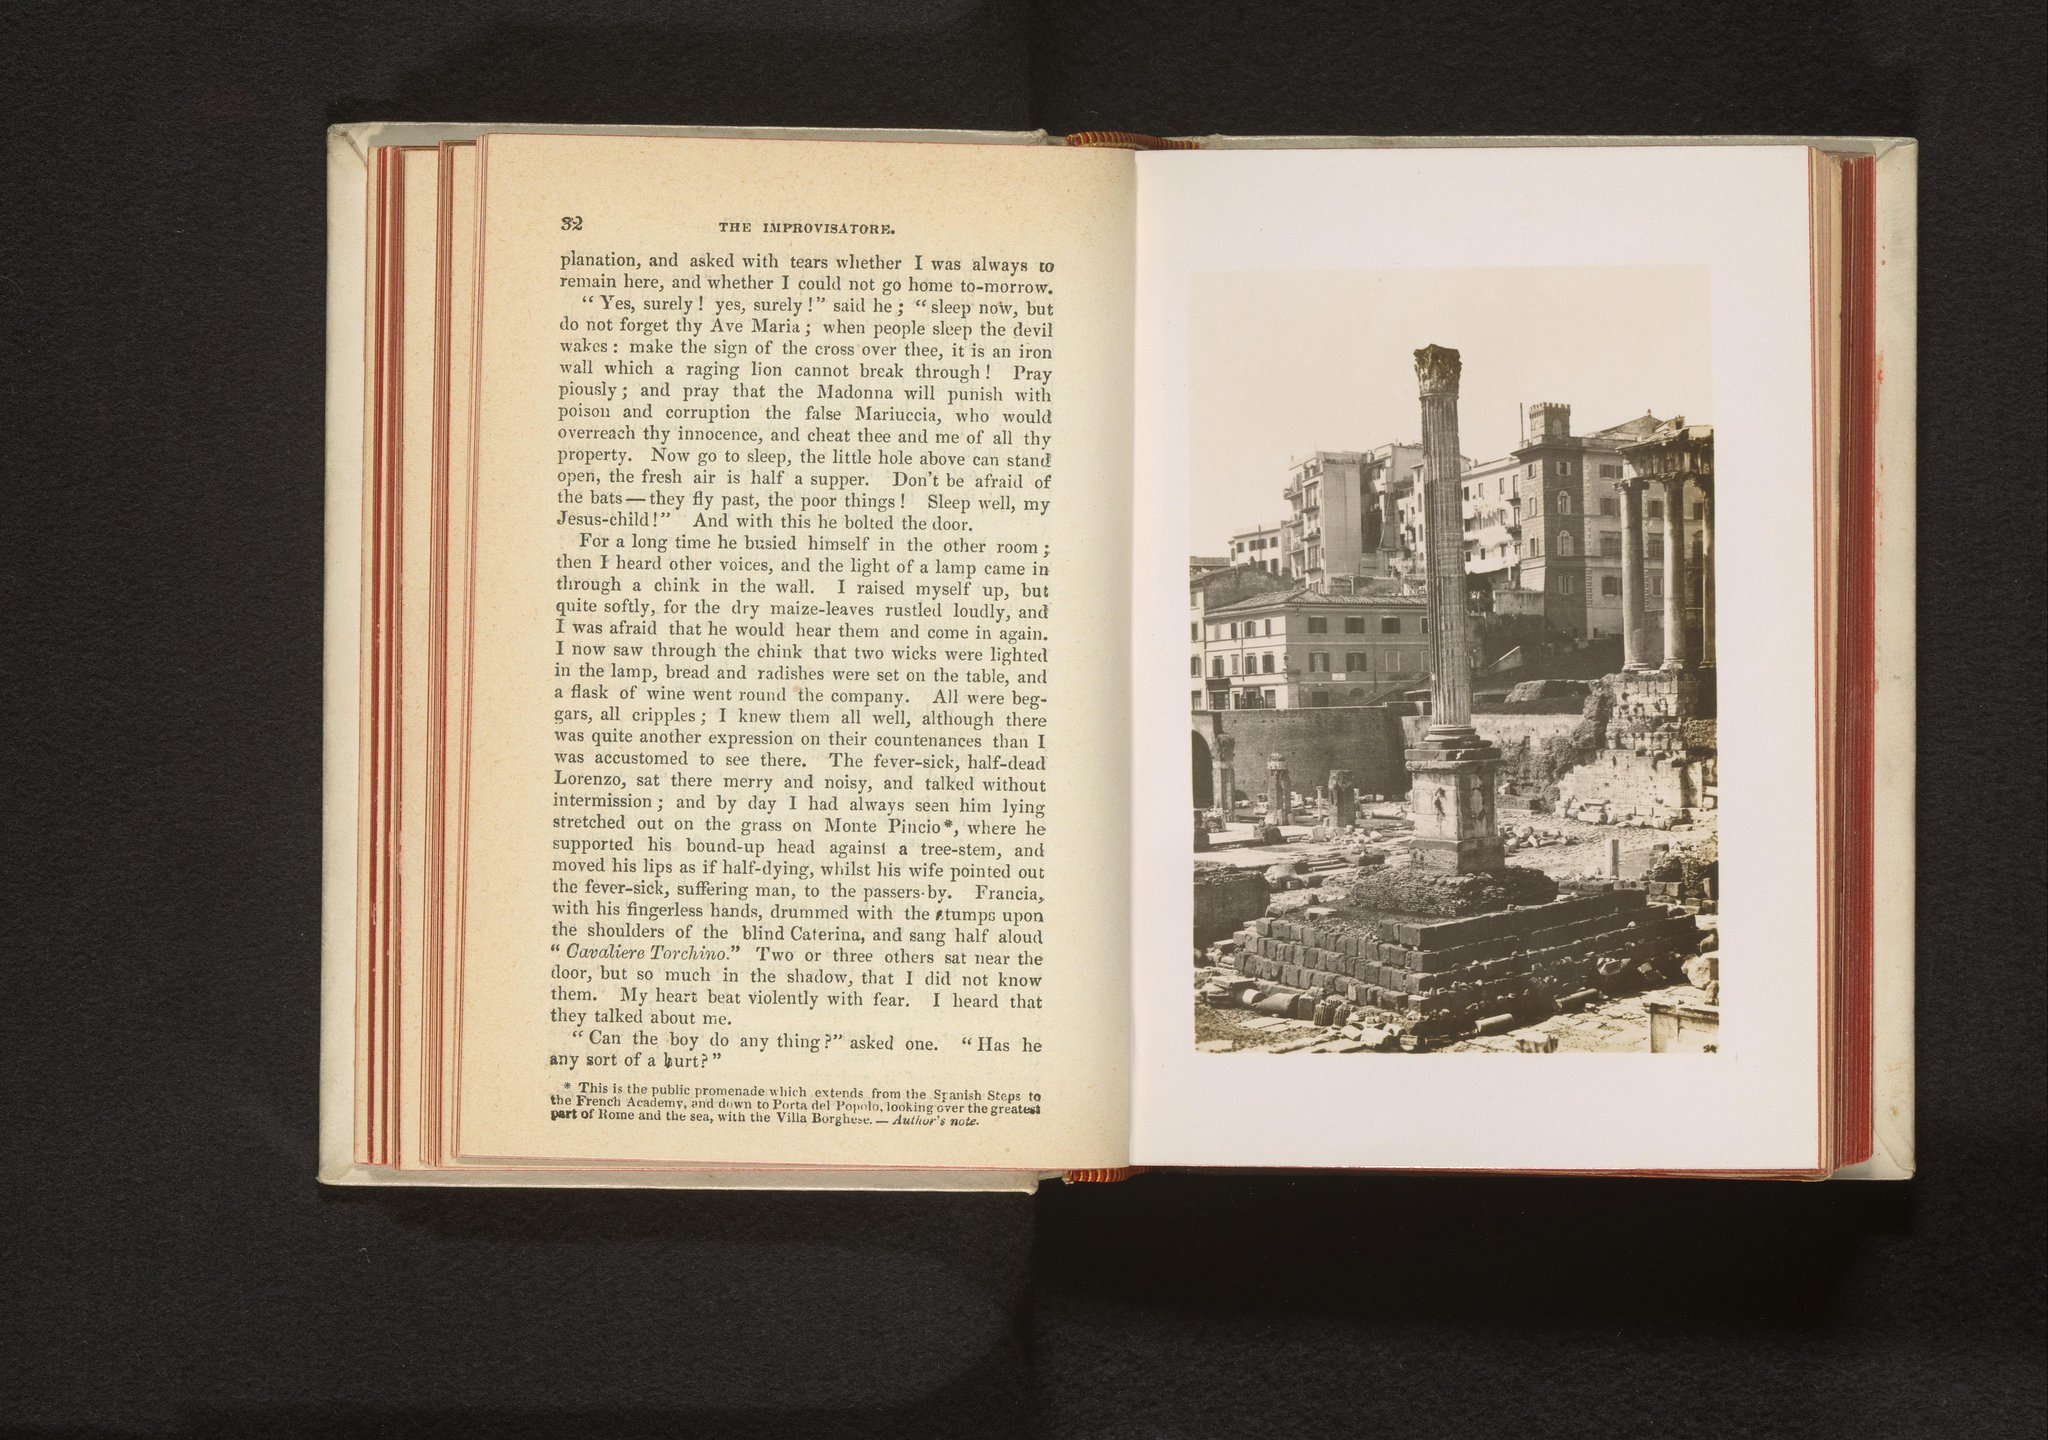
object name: photograph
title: Zuil van Phocas op het Forum Romanum te Rome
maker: Anonymous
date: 1870-1880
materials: photographic support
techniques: gelatin silver print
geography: forum romanum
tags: column, pillar ~ architecture, landscape with ruins